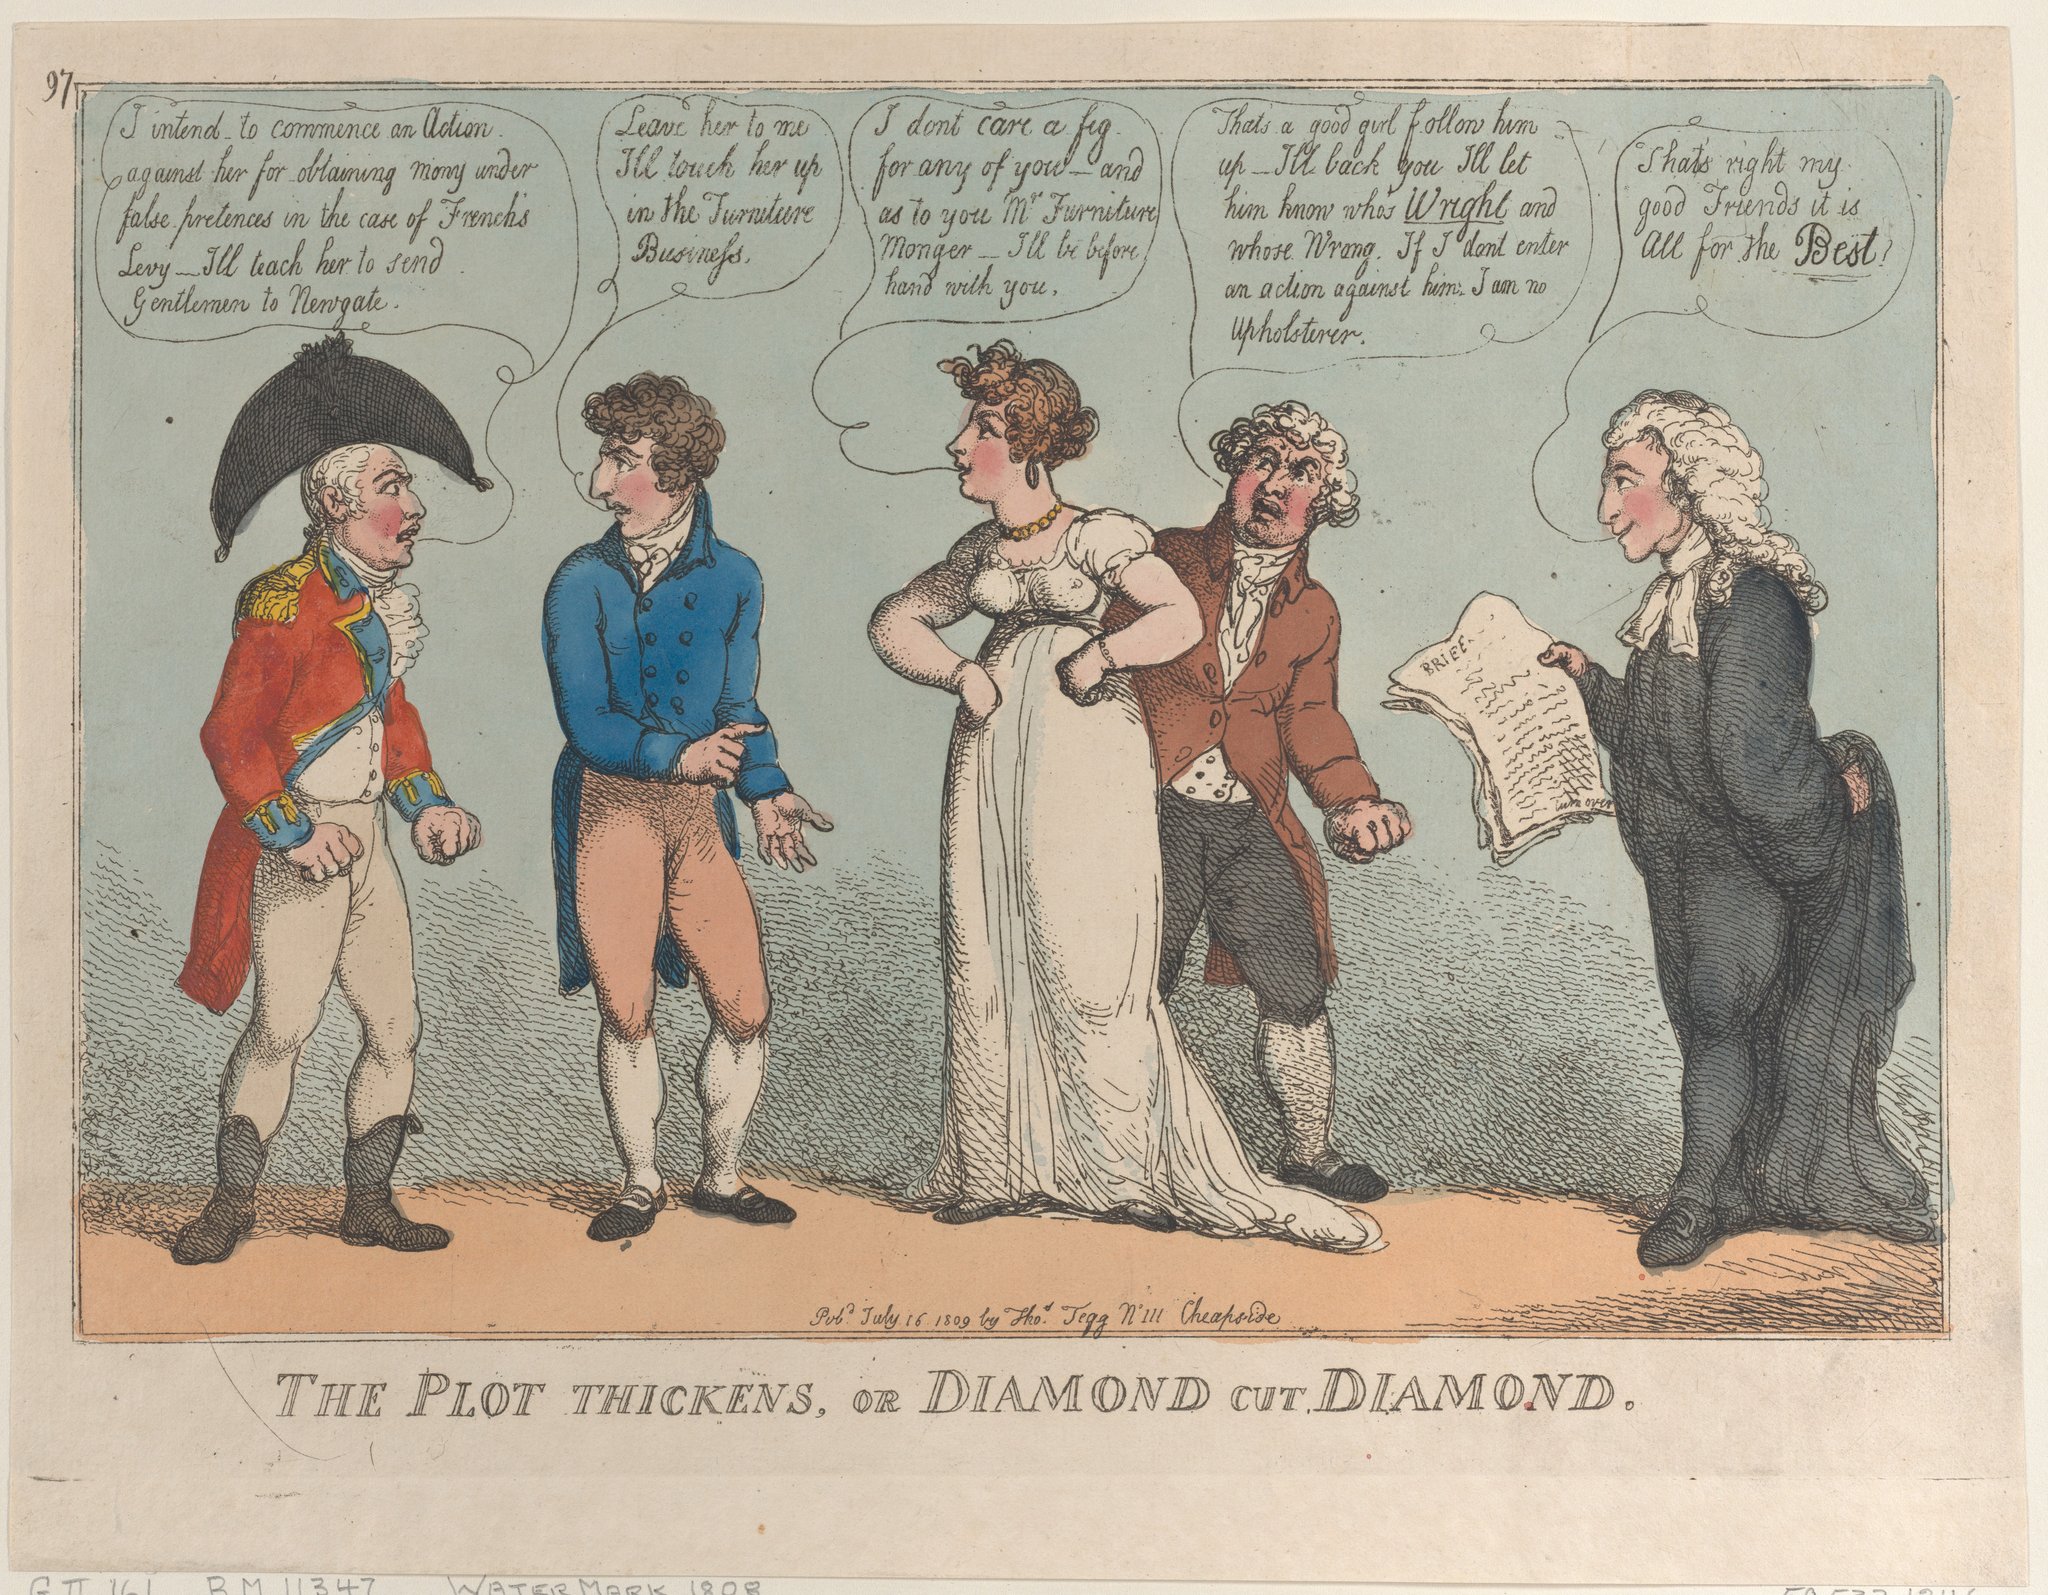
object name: print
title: The Plot Thickens, or Diamond Cut Diamond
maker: thomas rowlandson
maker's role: artist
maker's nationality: british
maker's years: 1757-1827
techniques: etching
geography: london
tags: satire,men,women,politics